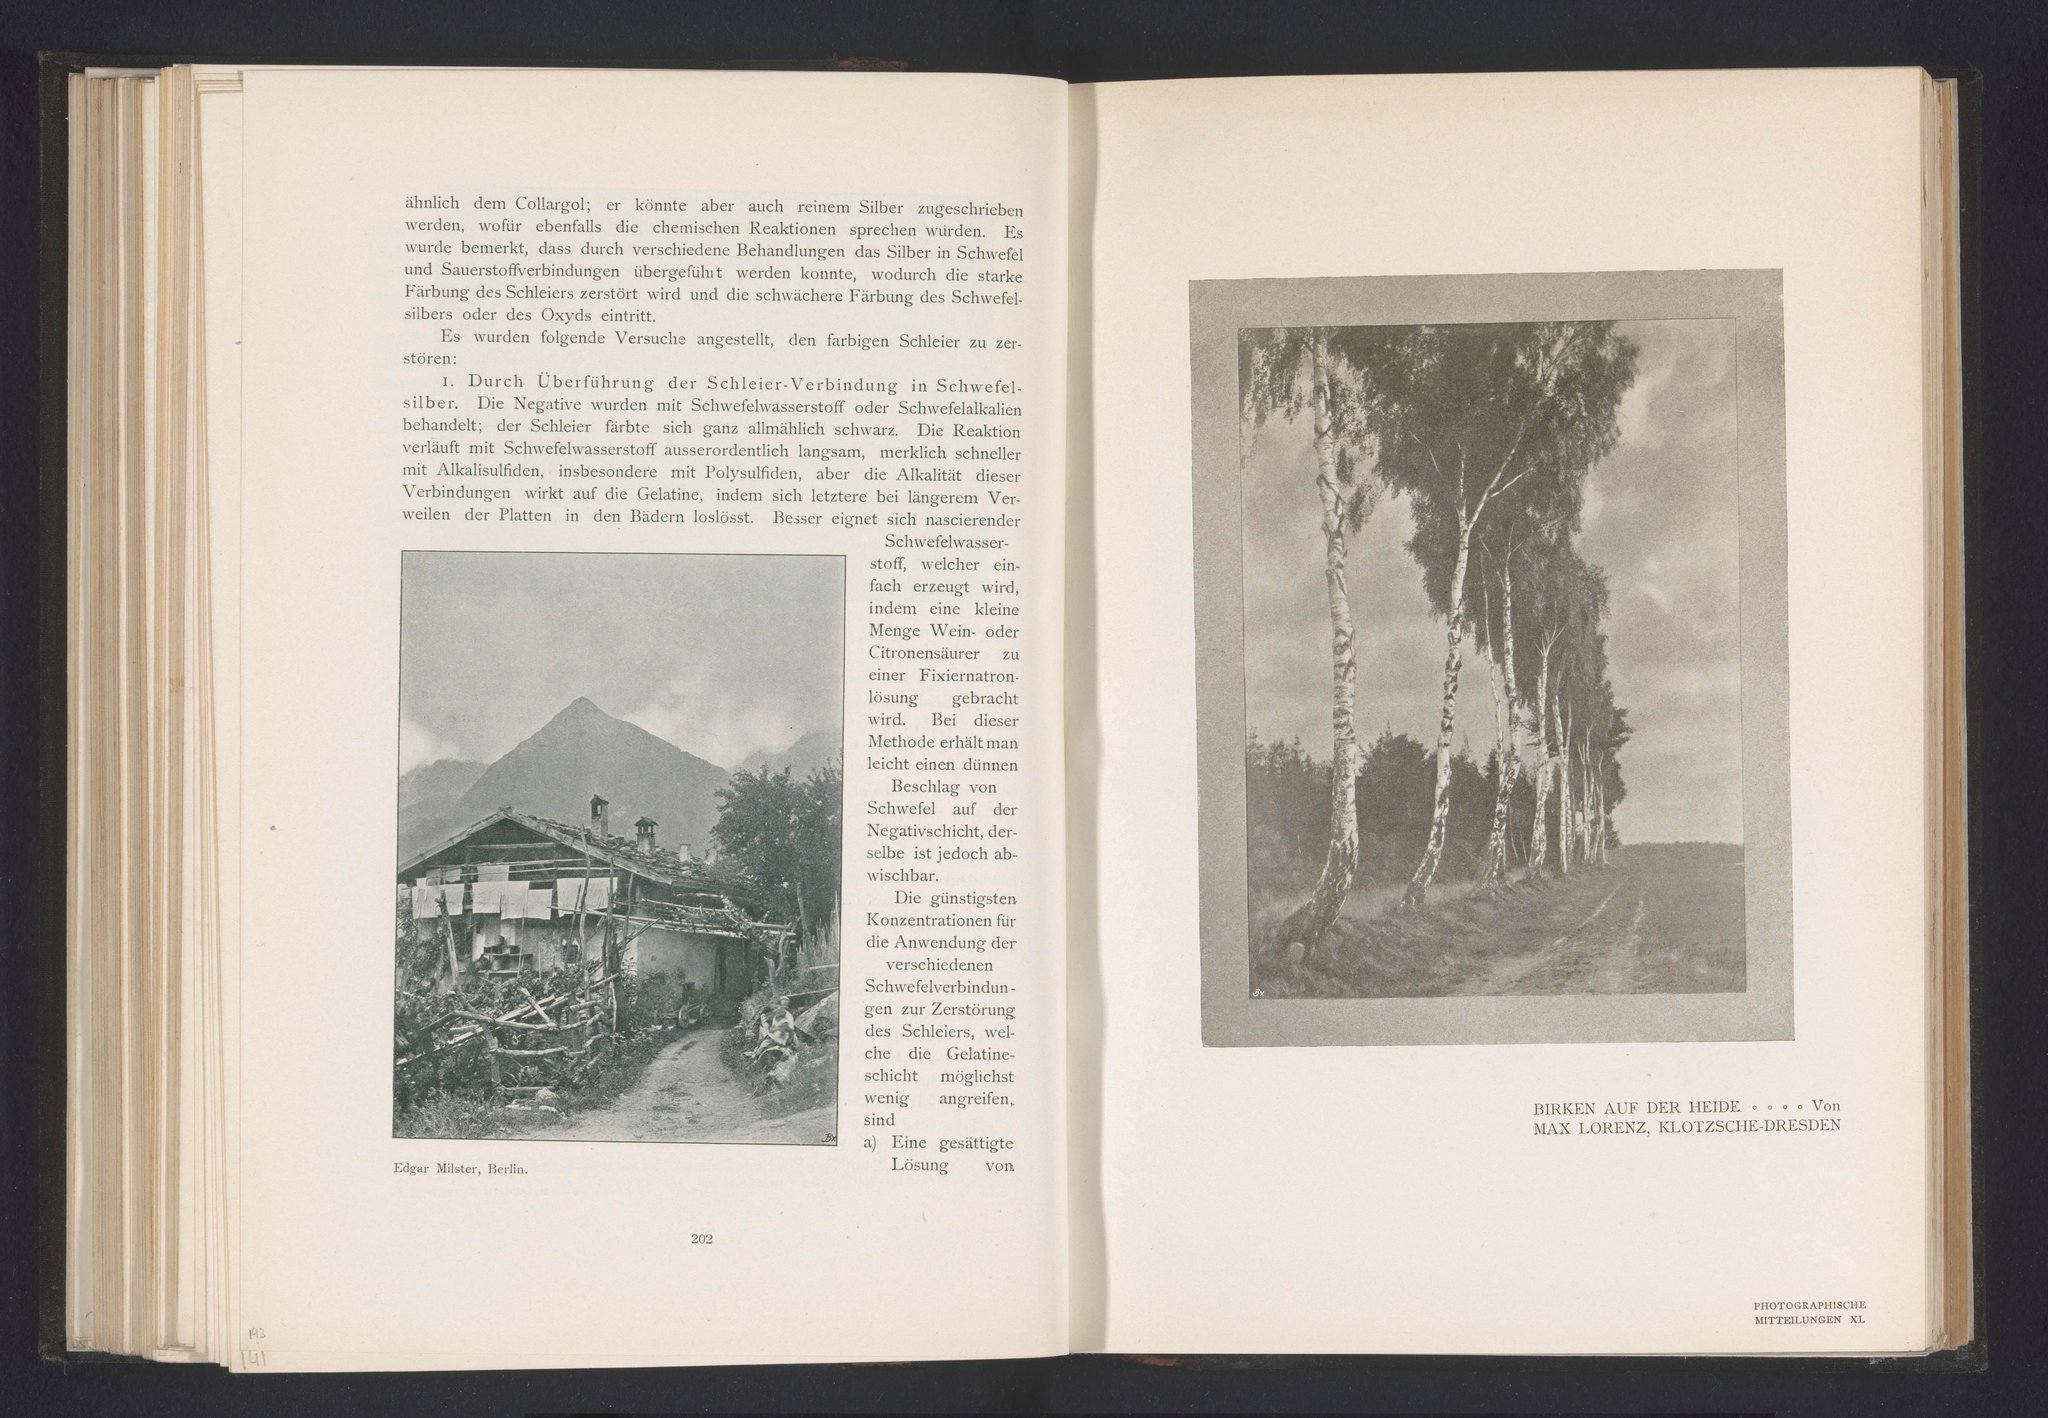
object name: page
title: Drie kinderen bij een huis in de bergen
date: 1898-1903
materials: paper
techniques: autotype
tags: façade (of house or building), mountains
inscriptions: monogram: ‘BX’